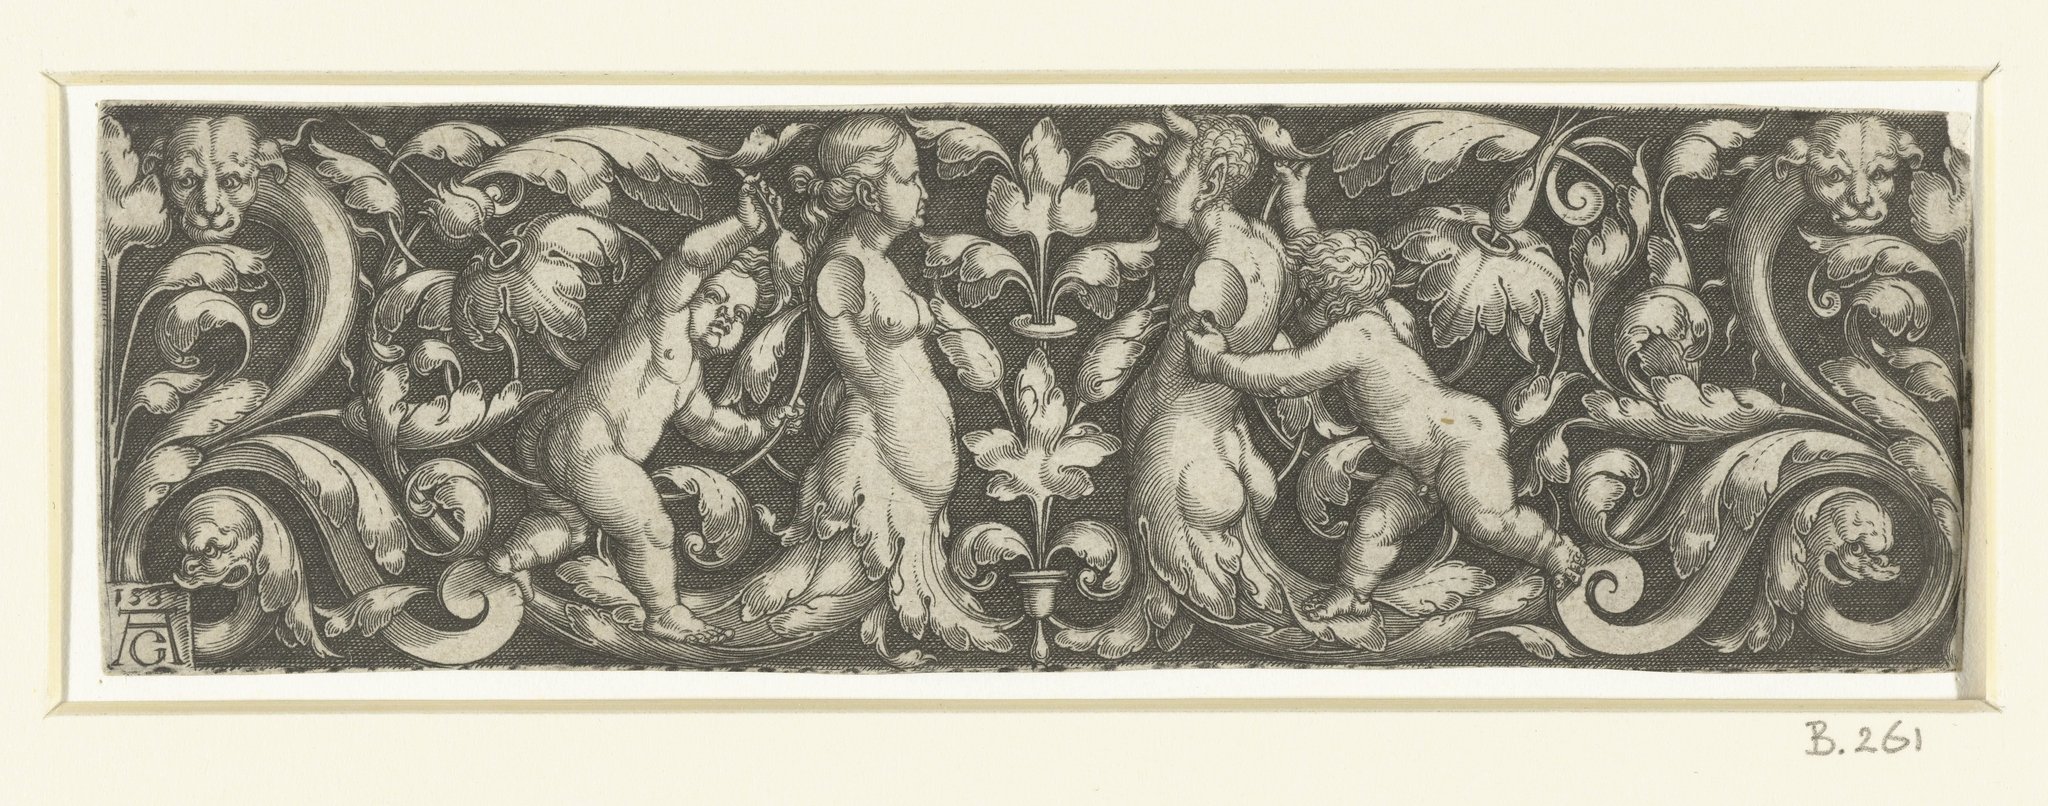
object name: ornament print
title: Fries met bladranken en figuren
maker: heinrich aldegrever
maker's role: draughtsman, print maker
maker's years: 1502-1561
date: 1537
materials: paper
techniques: engraving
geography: germany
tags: ornaments ~ art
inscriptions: number: ‘17’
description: Fries met een vrouw en een man, beiden zonder armen en met onderlichamen van bladranken, geflankeerd door twee kinderen. Aan de uiteinden van het fries lopen aan weerszijden ranken uit in een hondekop en een vissenkop.